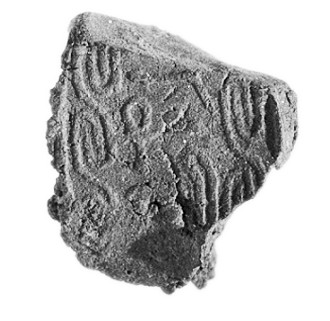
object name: sealing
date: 1981-1640 BCE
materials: mud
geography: egypt